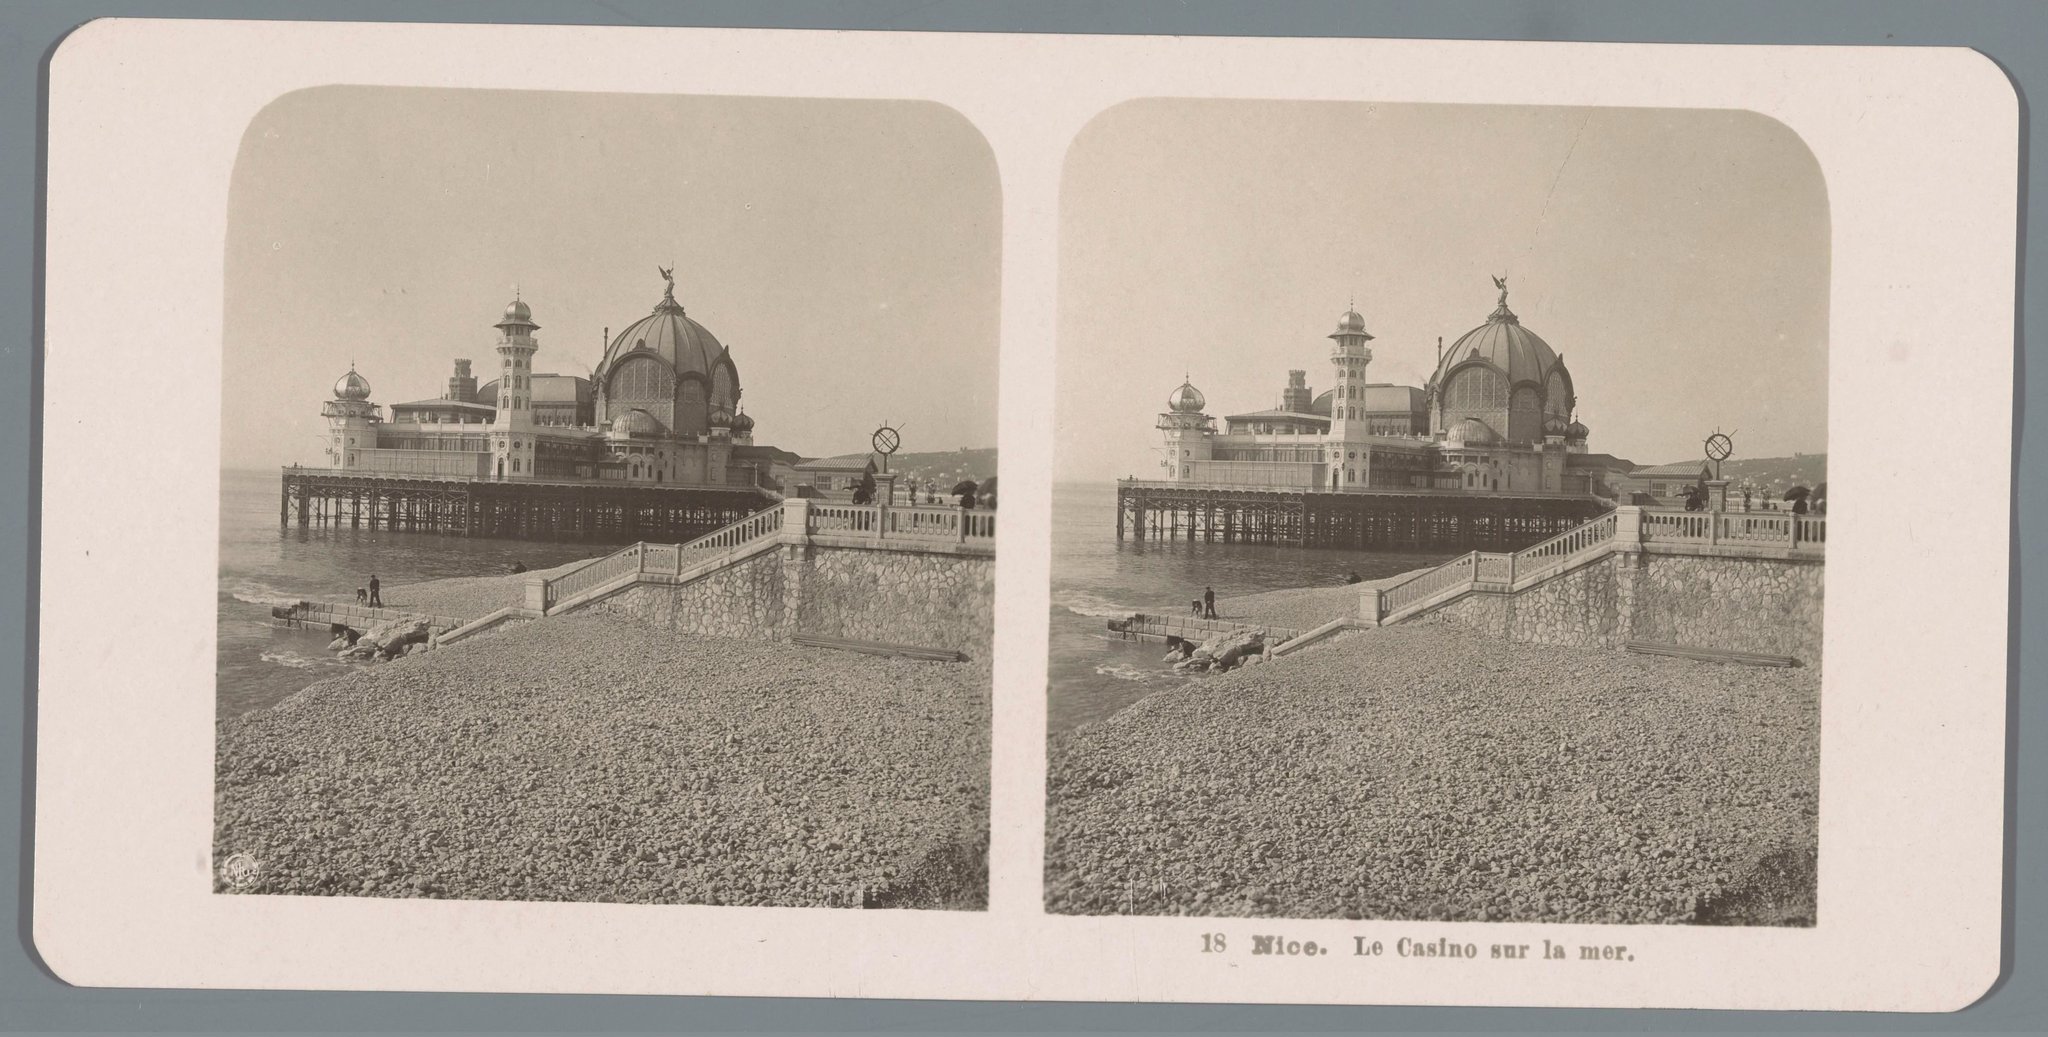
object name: stereograph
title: Gezicht op het casino van Nice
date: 1904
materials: cardboard, photographic support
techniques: gelatin silver print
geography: nice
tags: casino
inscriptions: inscription: ‘NPG’, number: ‘18’